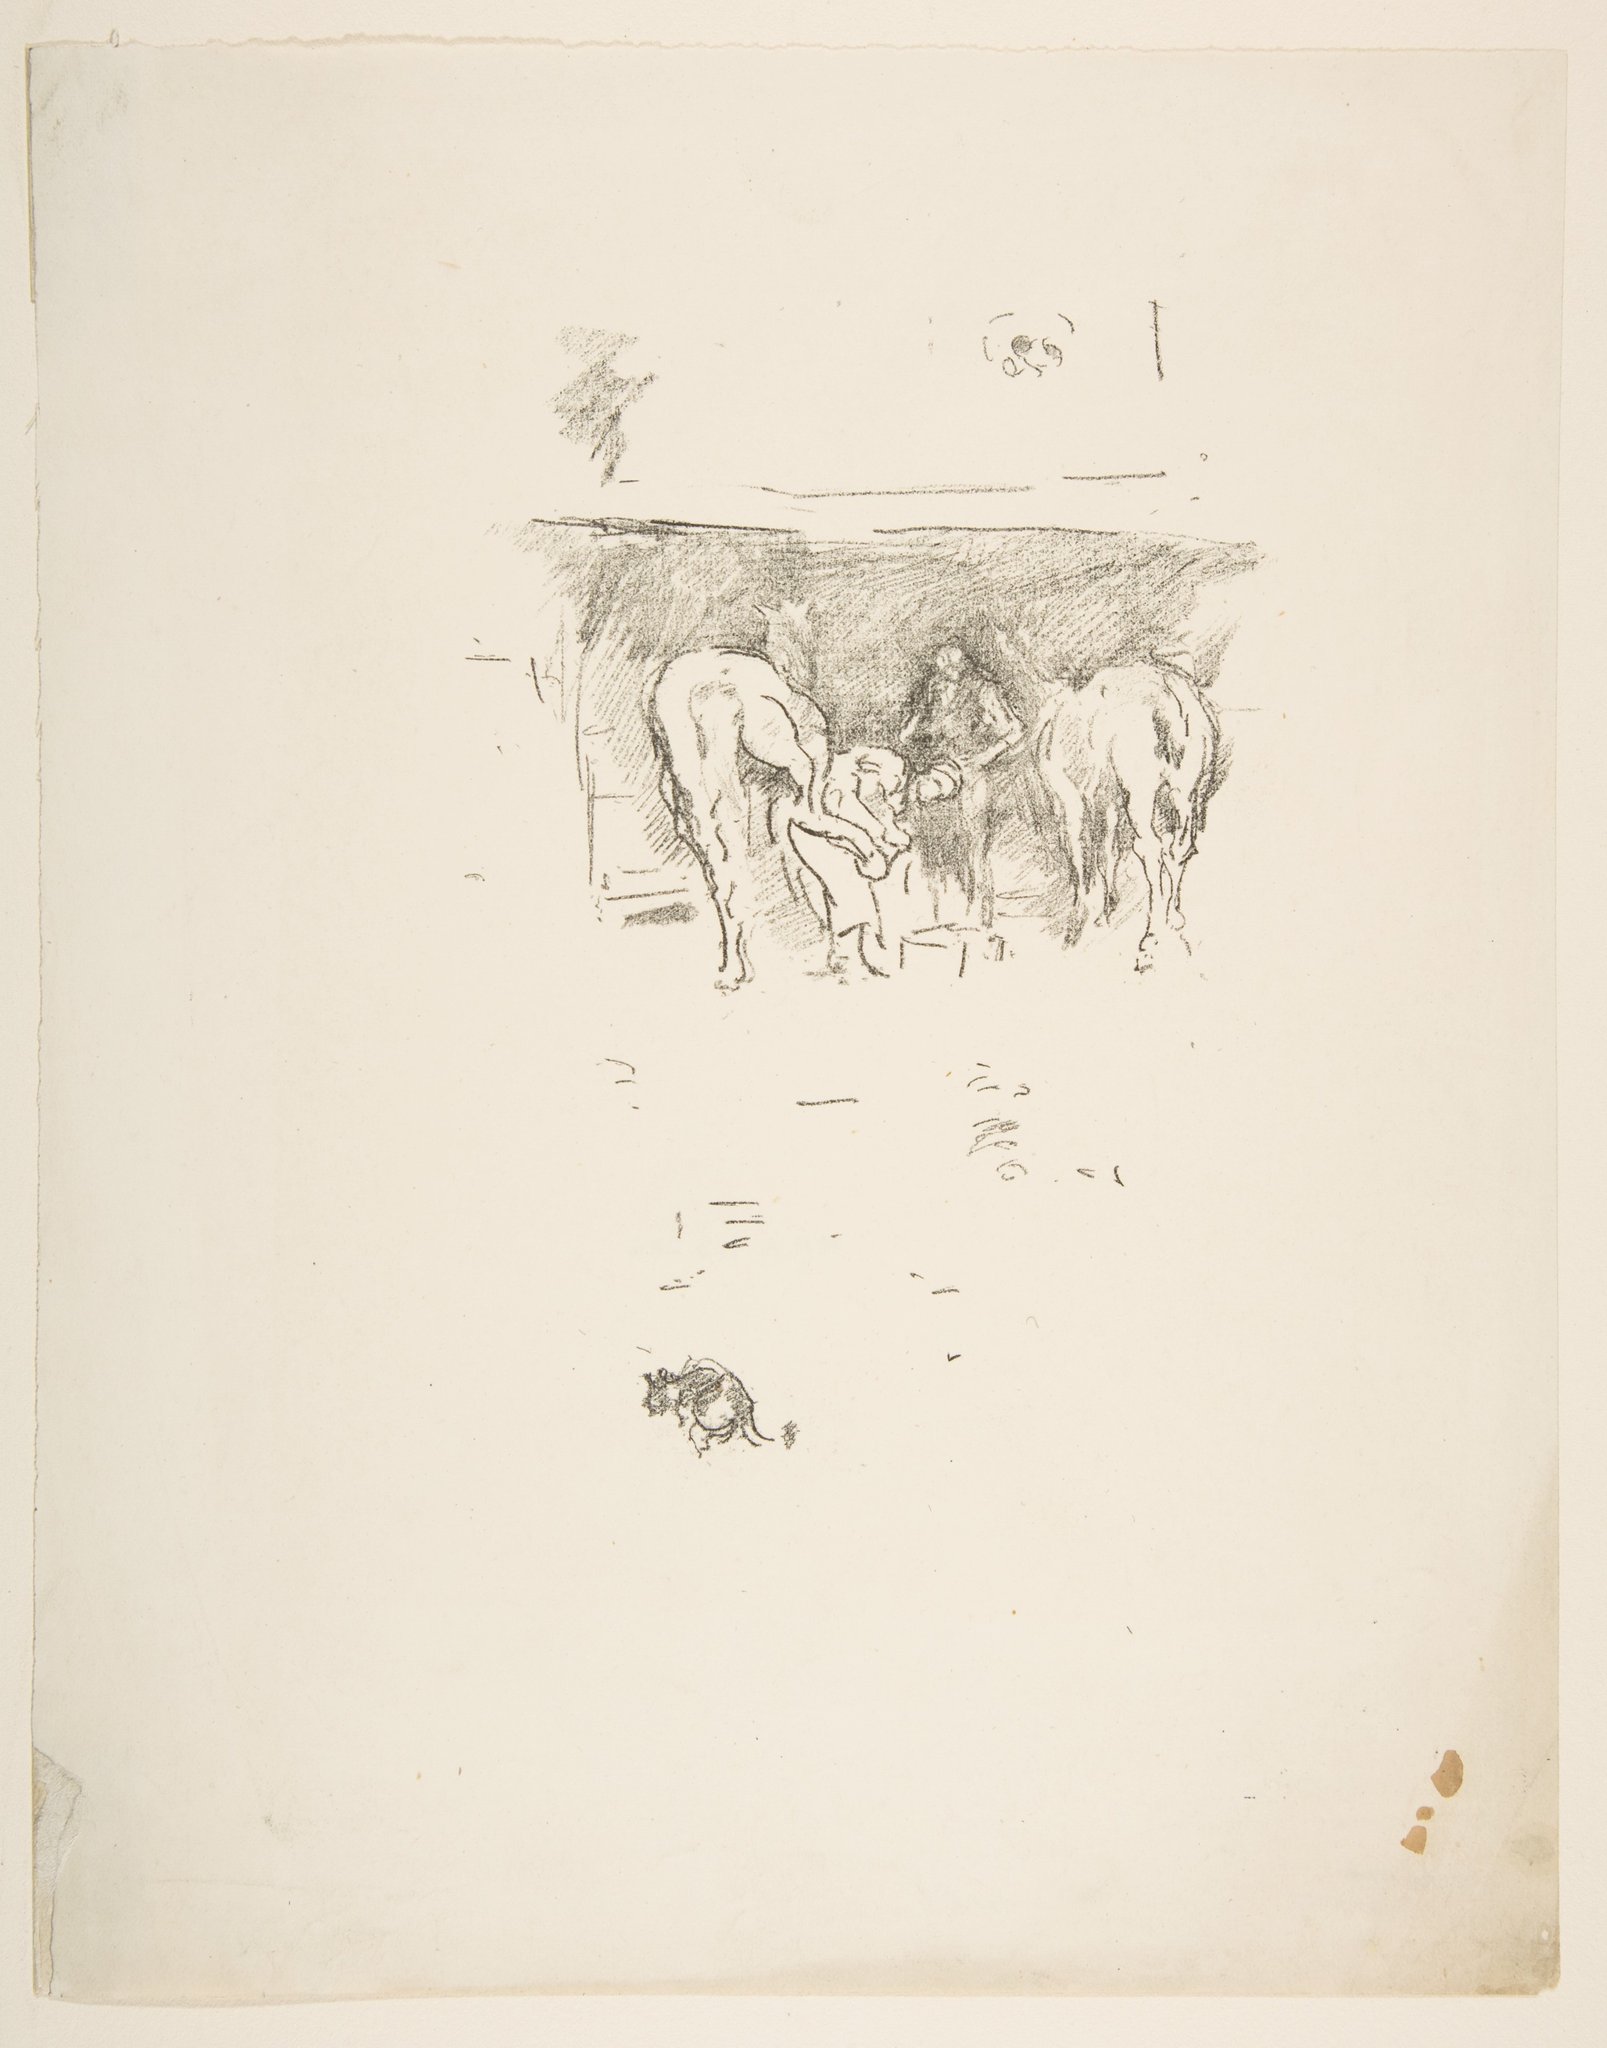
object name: print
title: The Good Shoe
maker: james mcneill whistler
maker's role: artist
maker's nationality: american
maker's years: 1834-1903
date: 1895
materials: ink, paper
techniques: printing, lithography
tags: human figures,horses